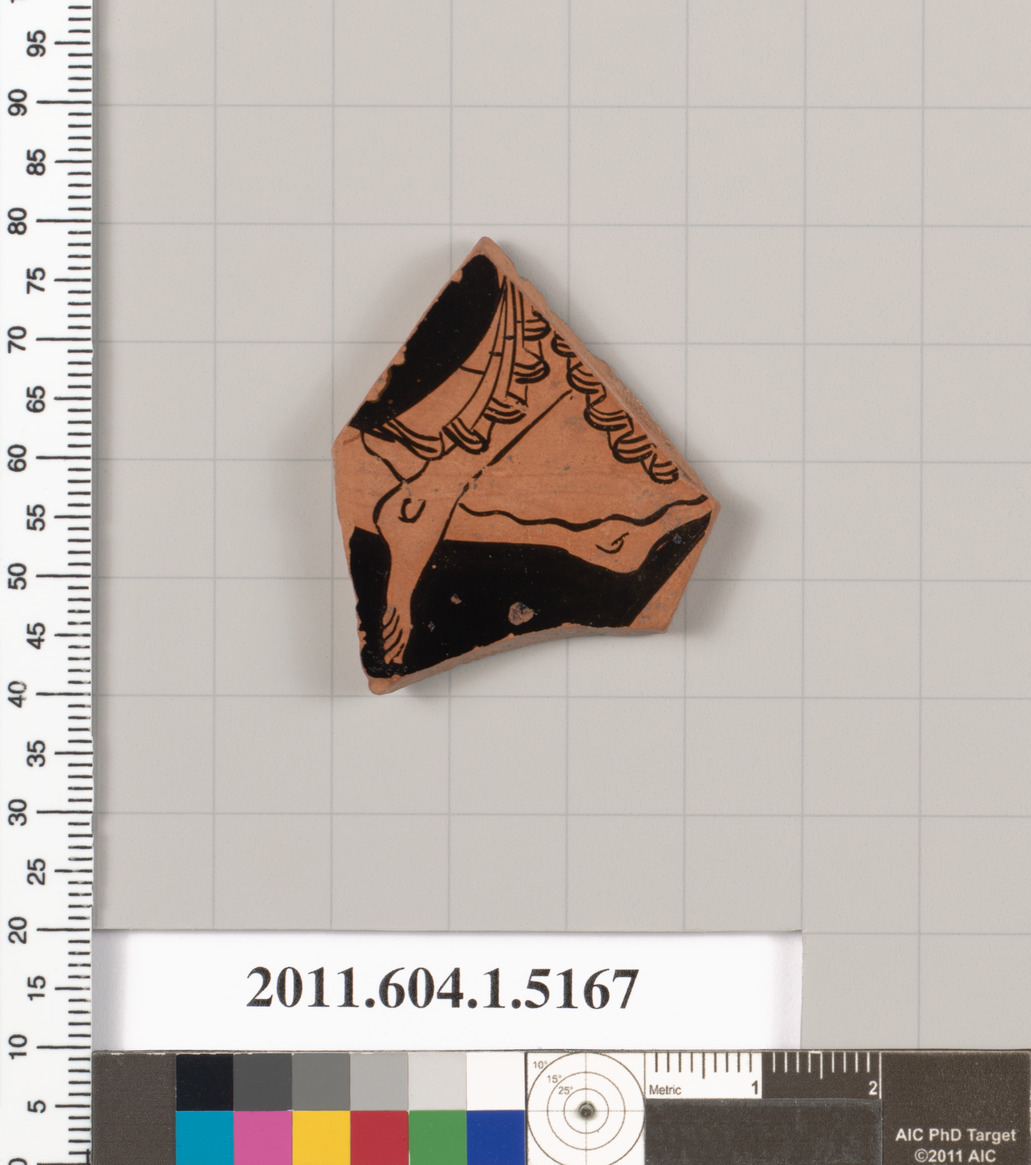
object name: kylix fragment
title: Terracotta fragment of a kylix (drinking cup)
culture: greek, attic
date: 500-480 BCE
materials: terracotta